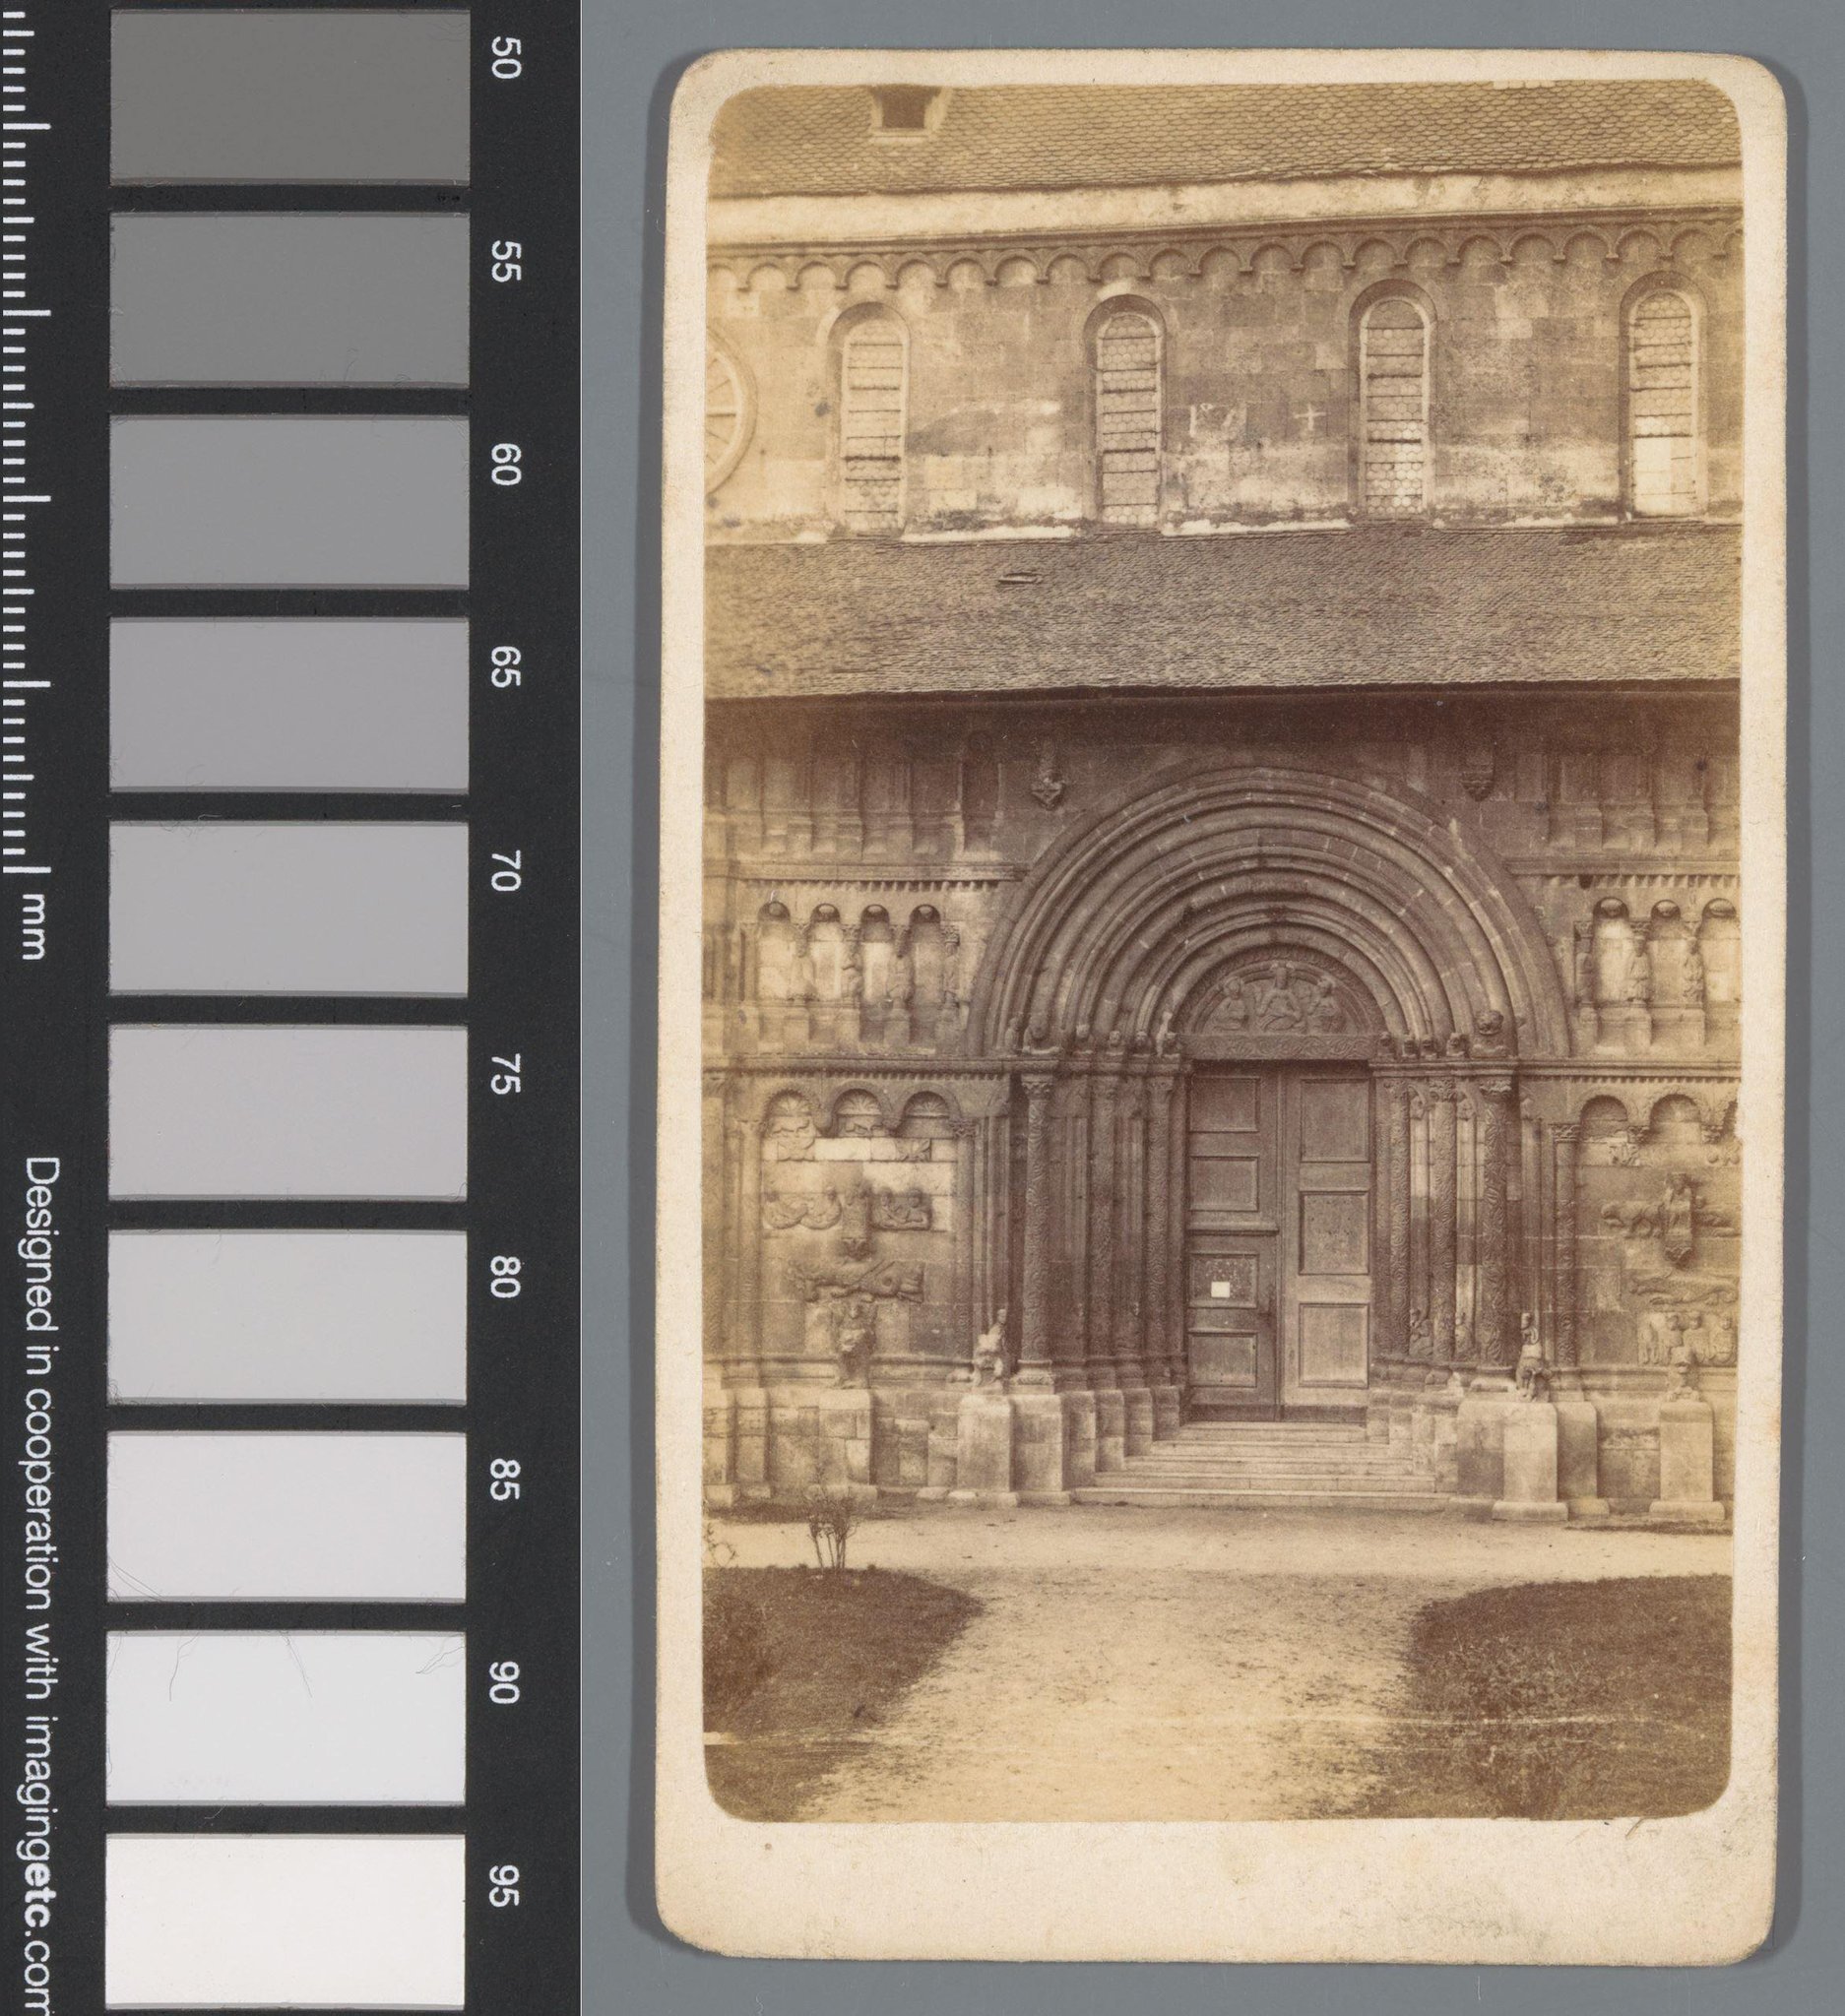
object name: carte de visite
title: Schottenkirche Regensburg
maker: johann laifle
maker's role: fotograaf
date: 1855-1885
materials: cardboard, paper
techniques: albumen print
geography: regensburg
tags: parts of church exterior and annexes: portal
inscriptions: inscription: ‘JOH. LAIFLE/ PHOTOGRAPH/ in/ REGENSBURG.’